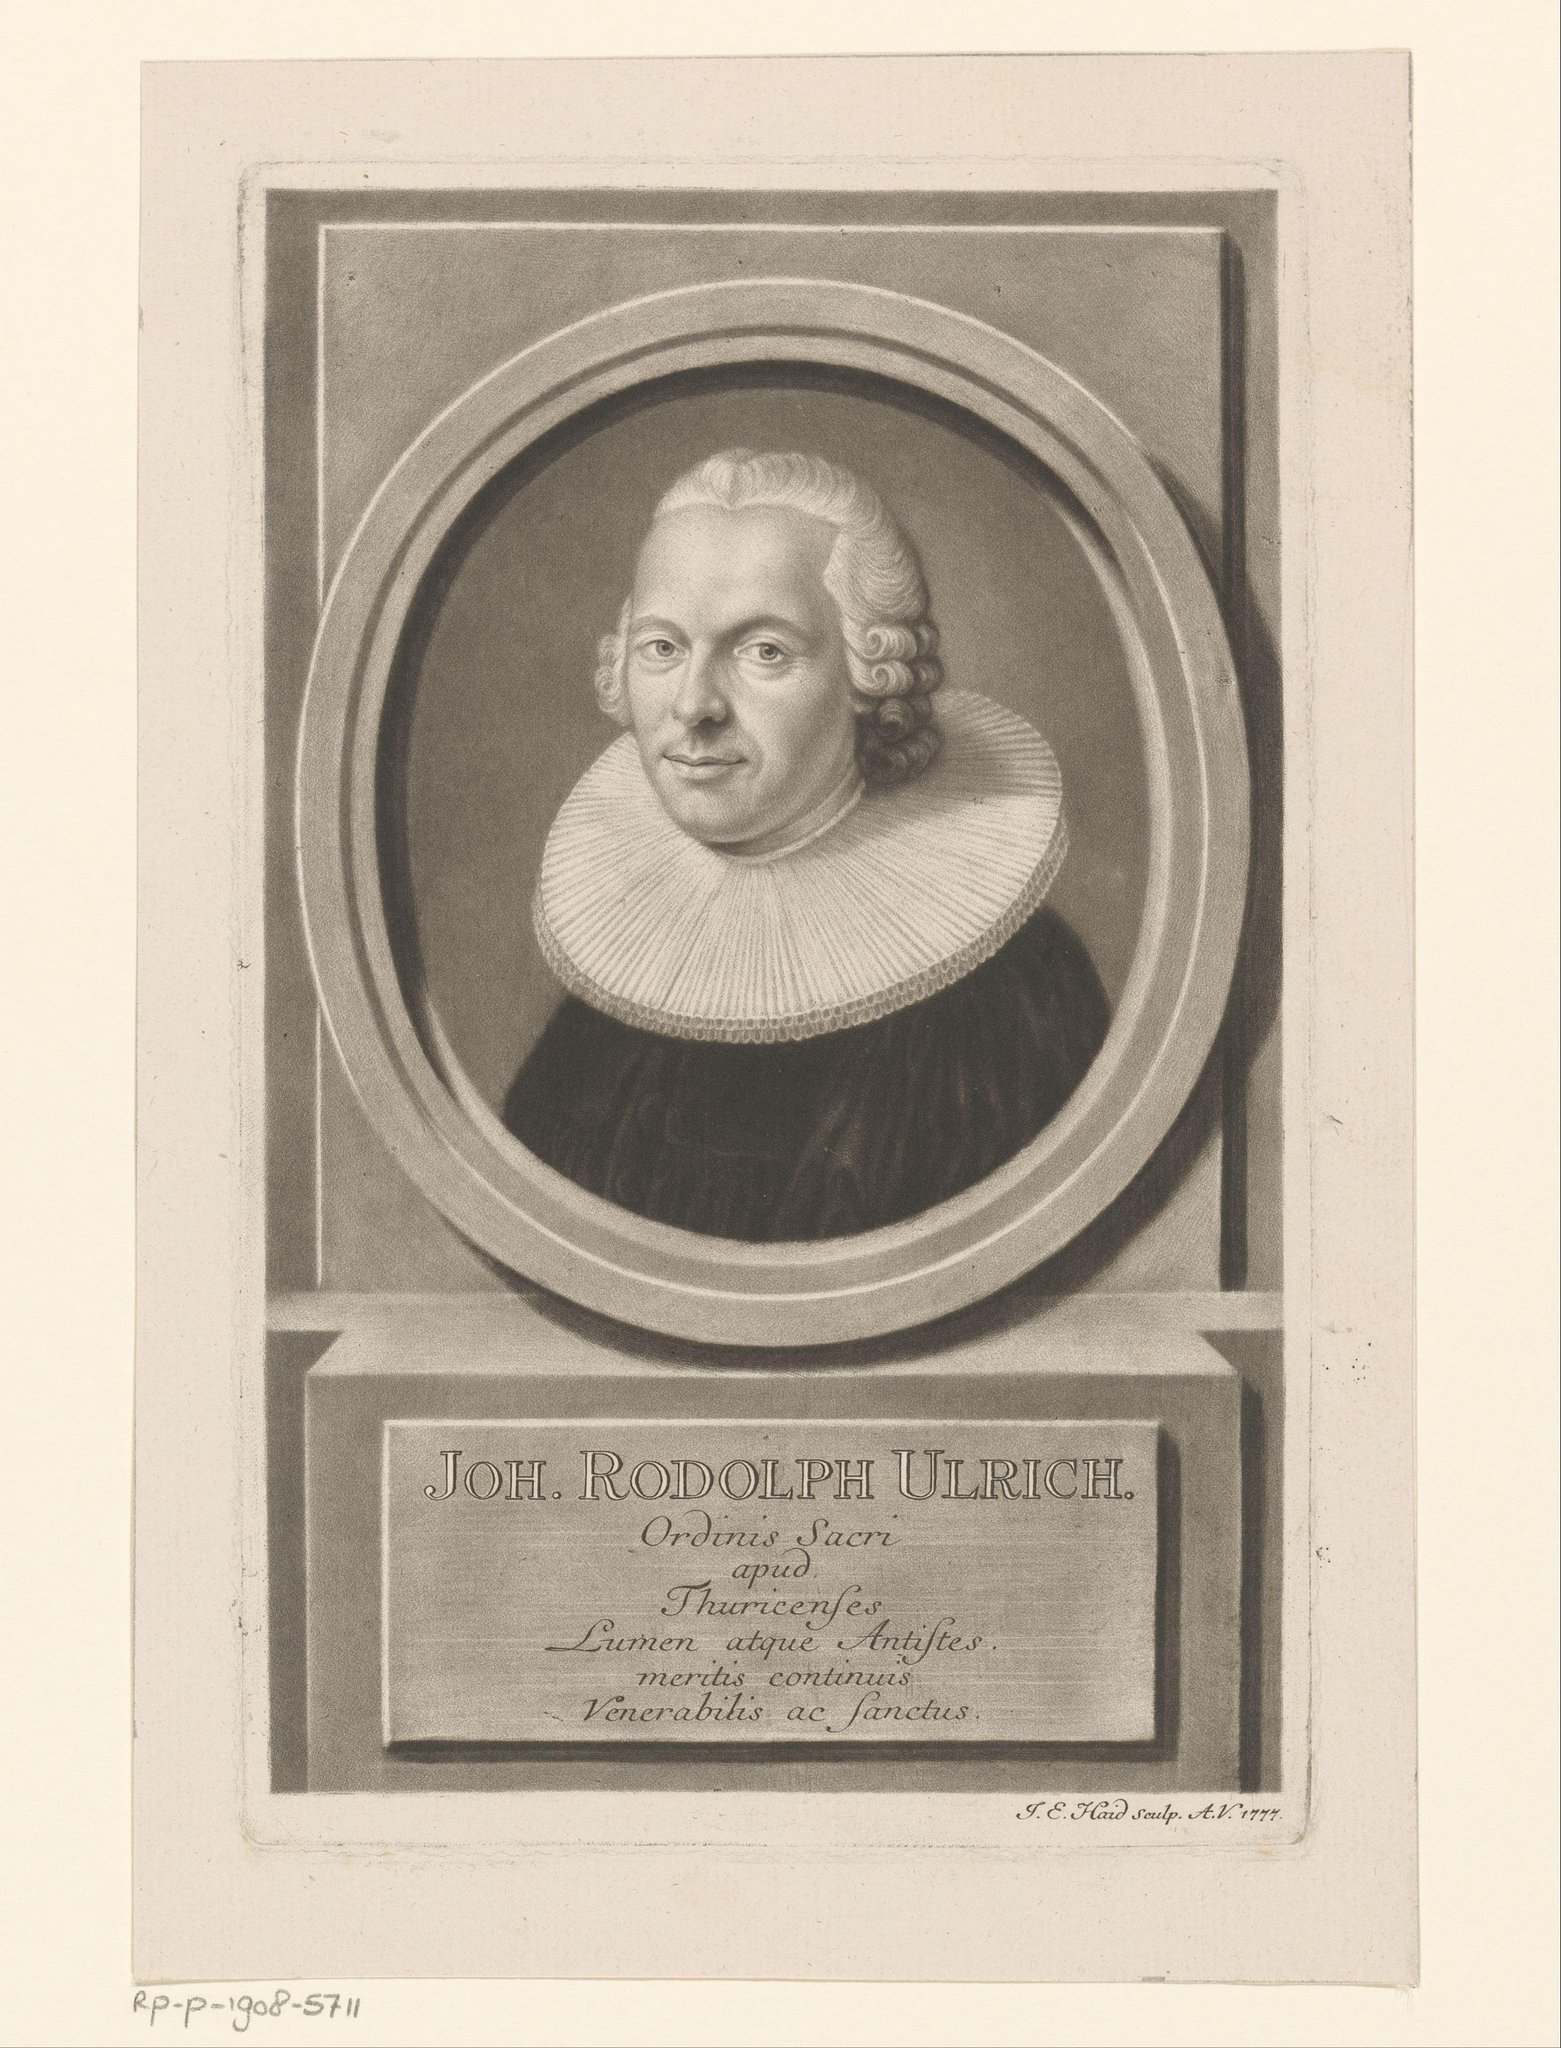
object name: print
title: Portret van Johann Rudolf Ulrich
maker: johann elias haid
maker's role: print maker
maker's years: 1739-1809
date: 1749-1809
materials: paper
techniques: mezzotint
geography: augsburg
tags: theologian, historical persons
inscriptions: collector's mark: Lugt 2228